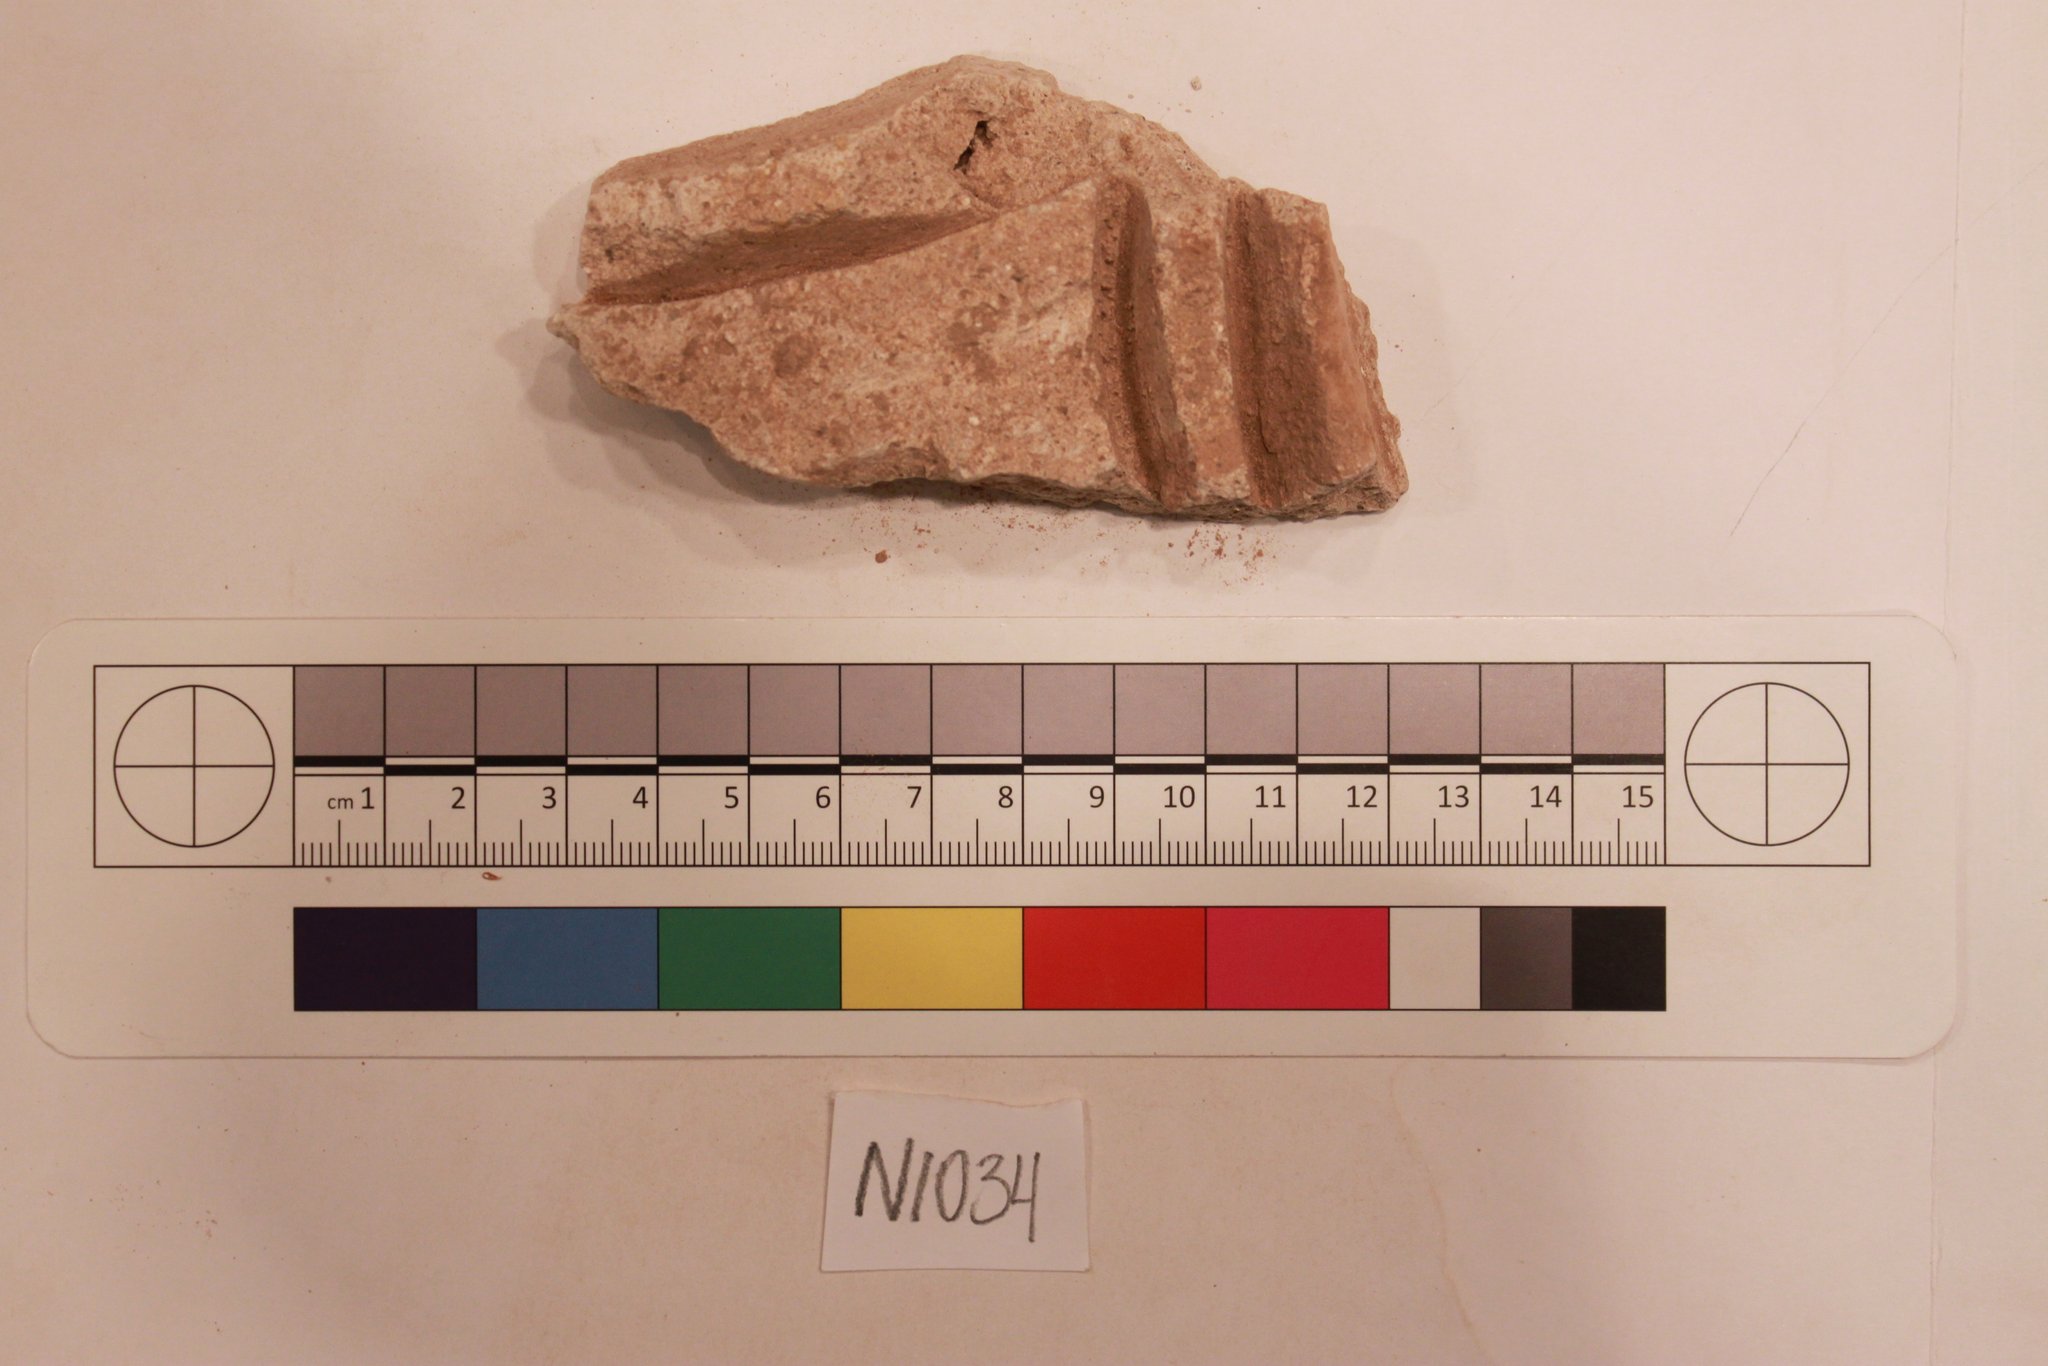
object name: fragment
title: Stucco Fragment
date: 701-1200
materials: plaster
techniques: carving, painting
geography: iran